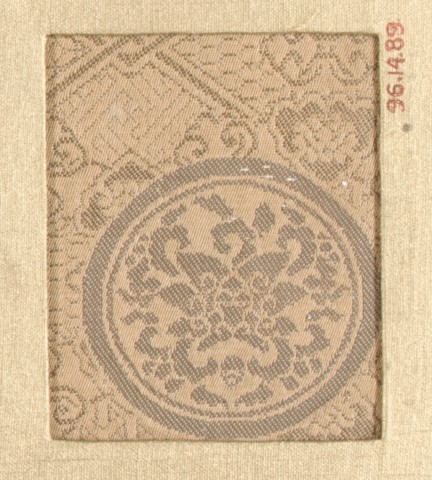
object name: piece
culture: japanese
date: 1701-1900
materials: silk